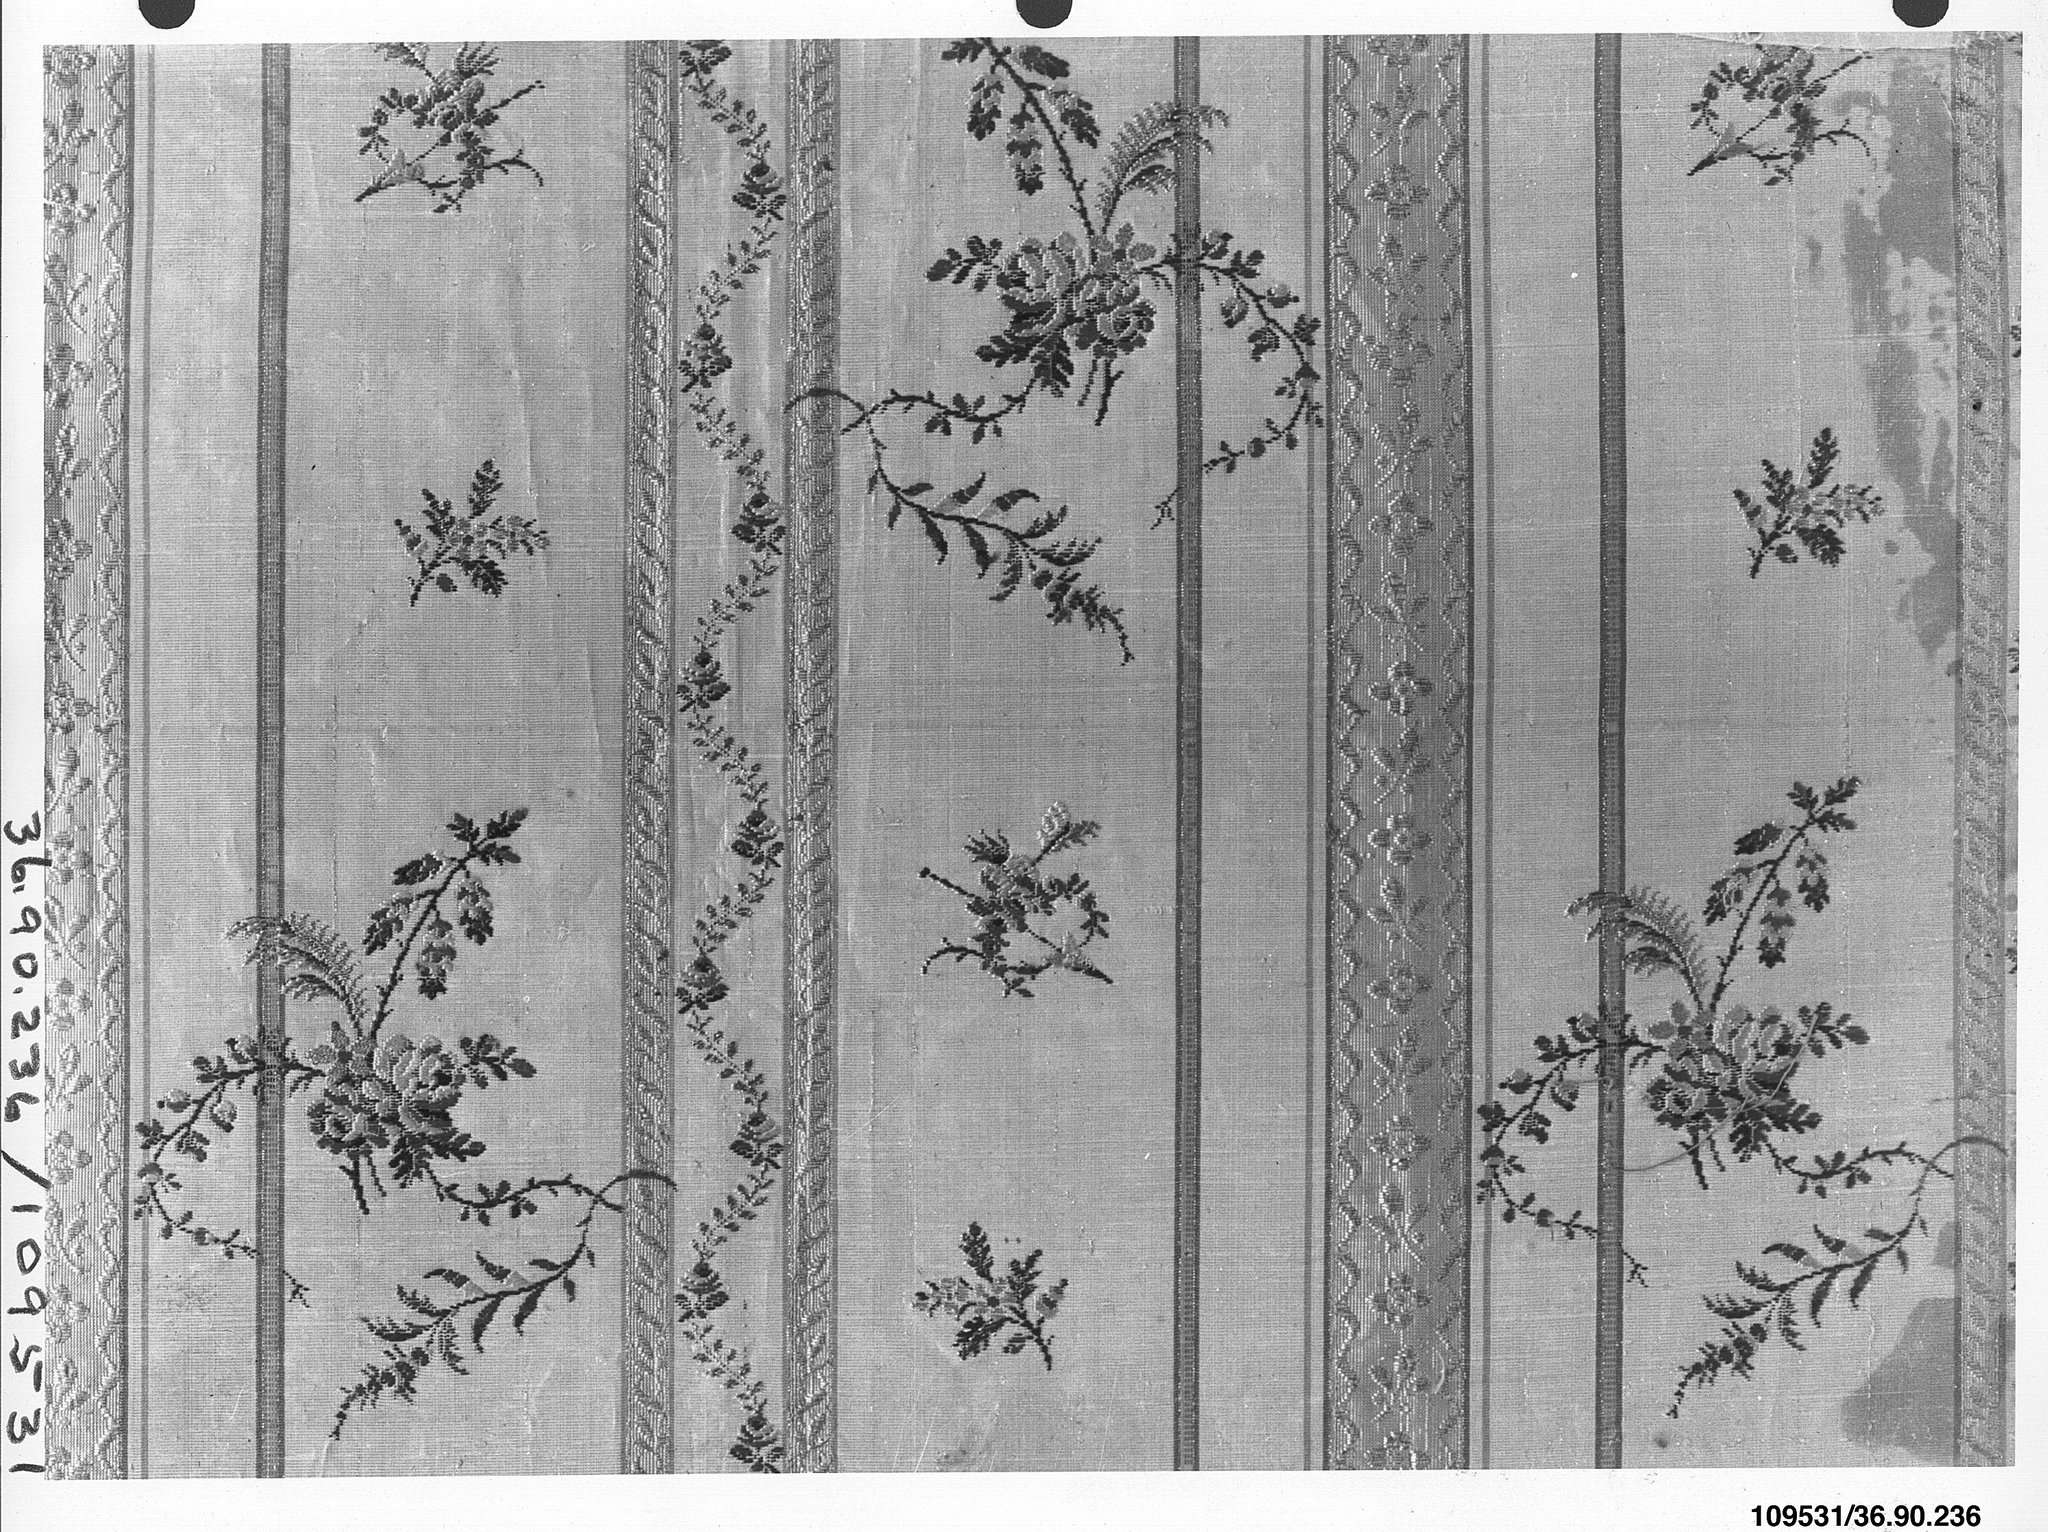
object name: piece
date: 1701-1800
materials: metal thread, silk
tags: flowers,leaves